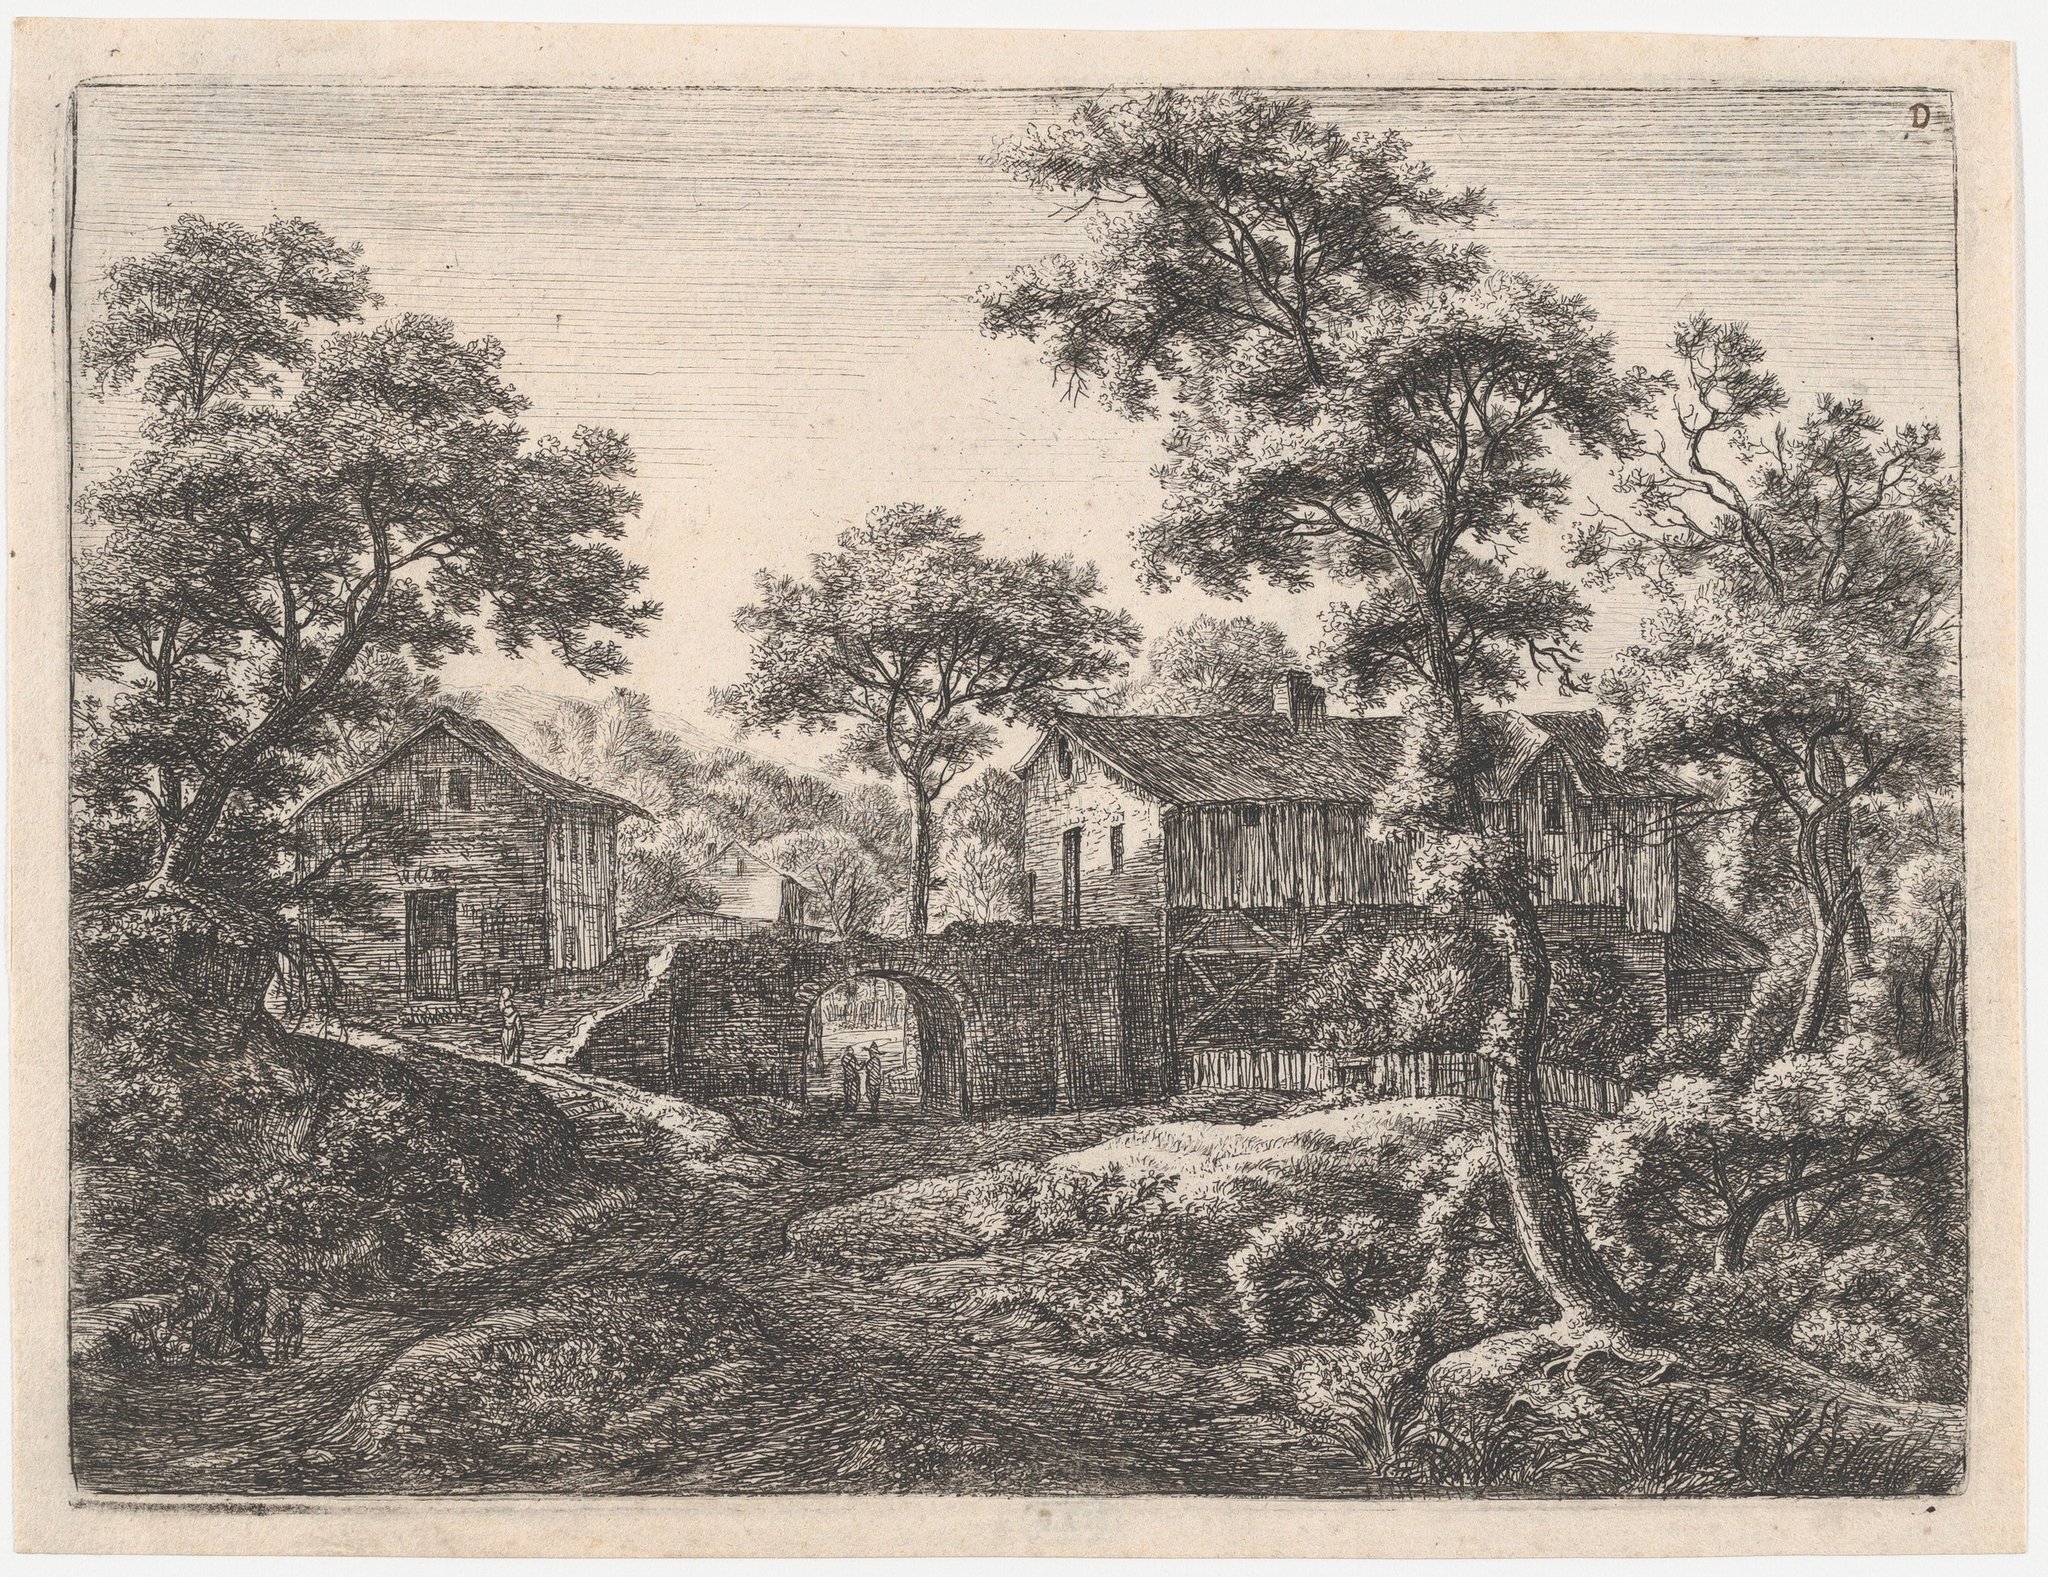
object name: print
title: The Gateway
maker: anthonie waterloo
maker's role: artist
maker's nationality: dutch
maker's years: 1609-1690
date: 1601-1700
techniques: etching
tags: buildings,landscapes